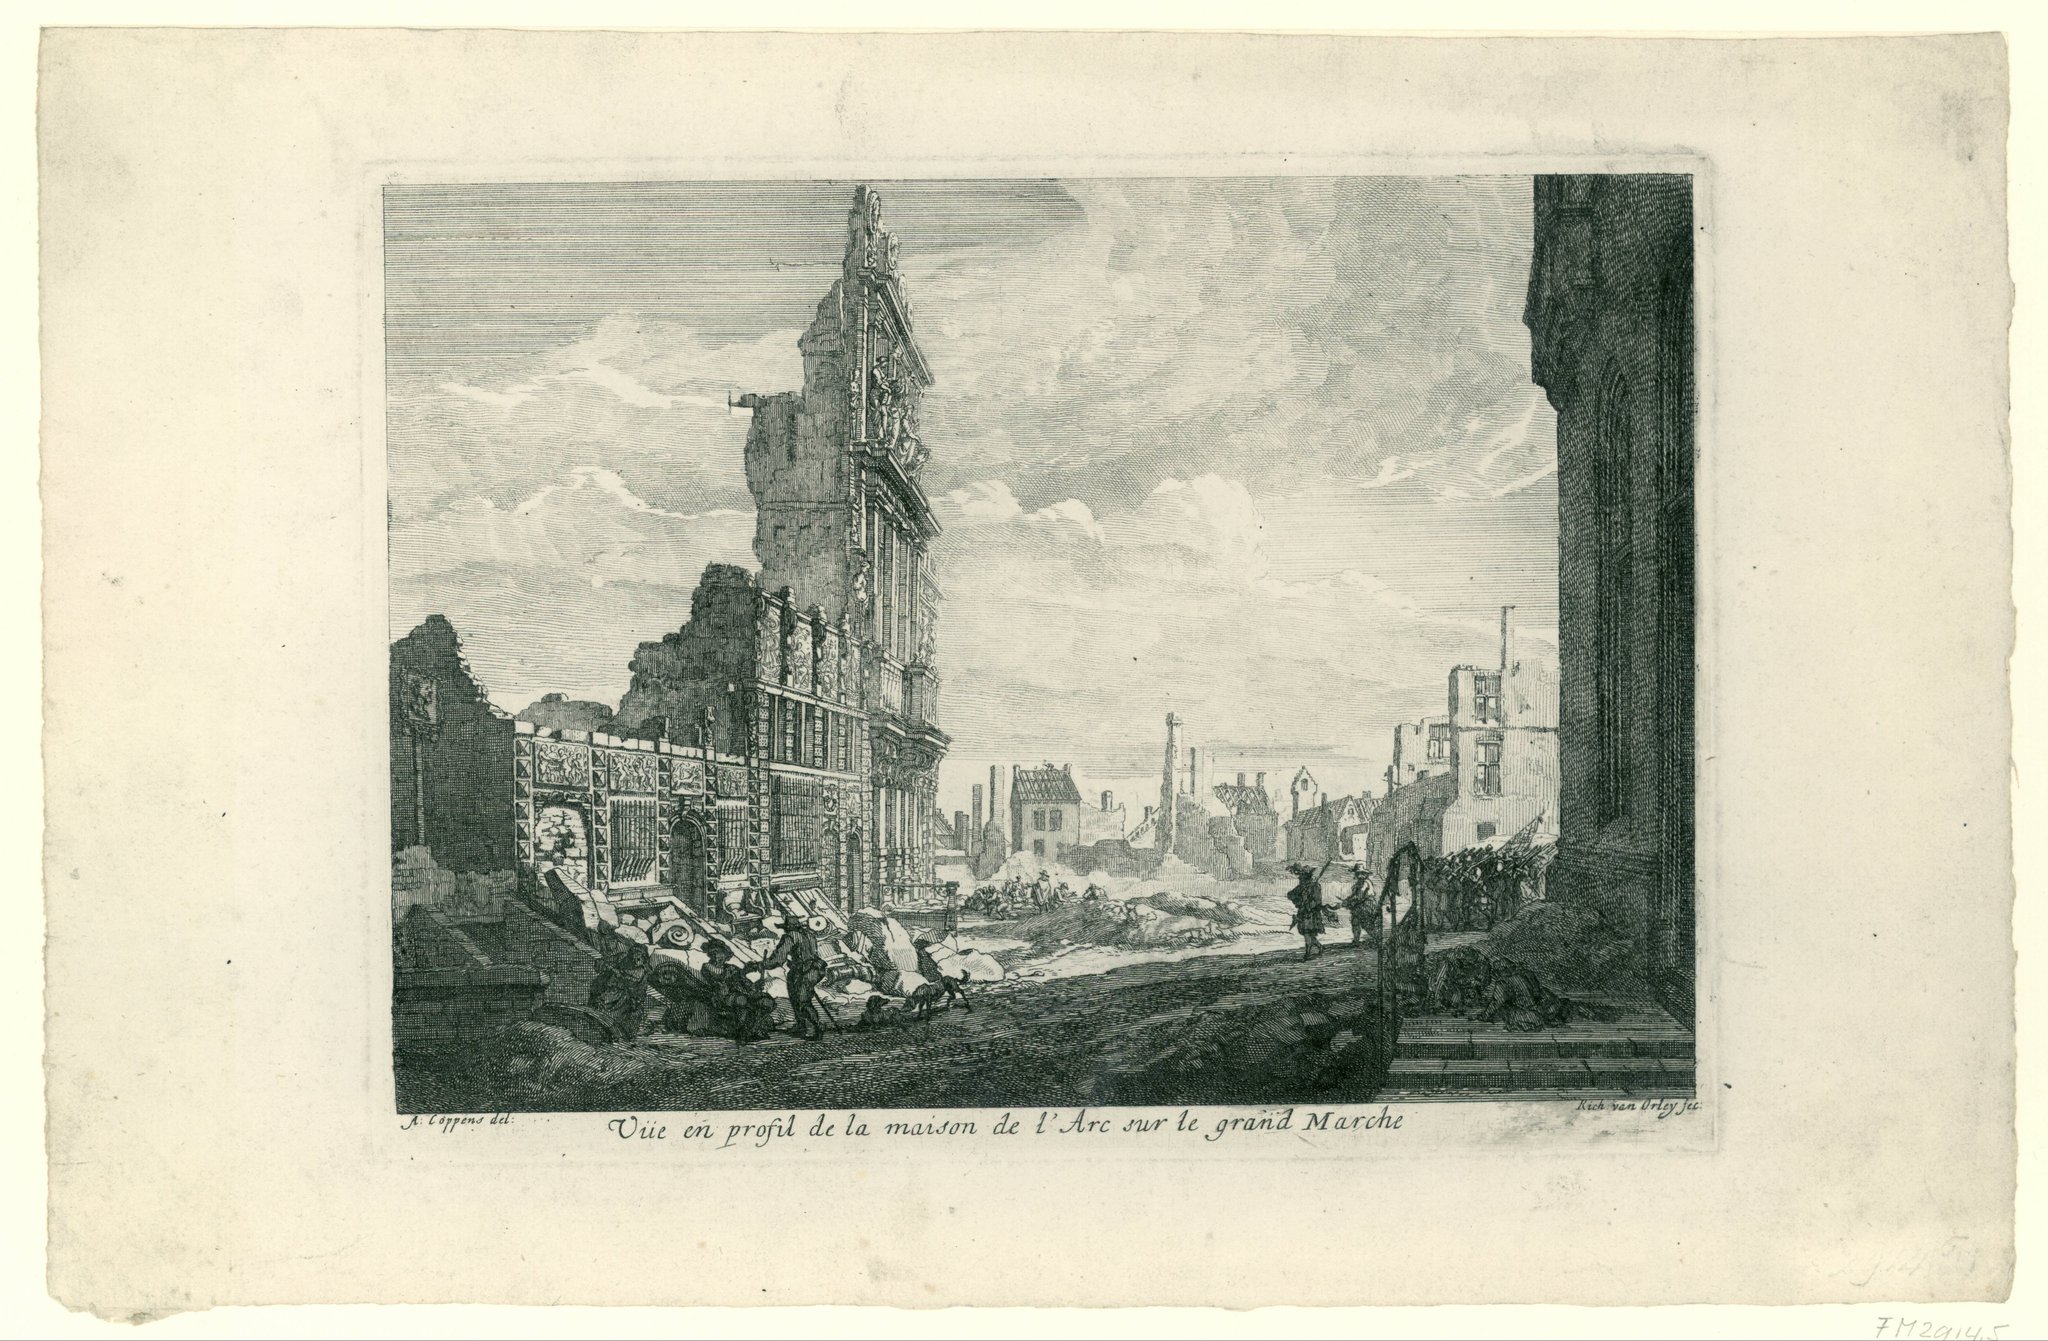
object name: print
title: Vue en profil de la maison de l'Arc sur le grand Marche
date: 1695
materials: paper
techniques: etching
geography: southern netherlands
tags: devastated, ruined place or city (~ warfare), brussels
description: Voorstelling van de ruïnes van Brussel bij de Grote Markt na het bombardement door de Fransen, 13-15 augustus 1695. Vijfde prent in de reeks van twaalf.